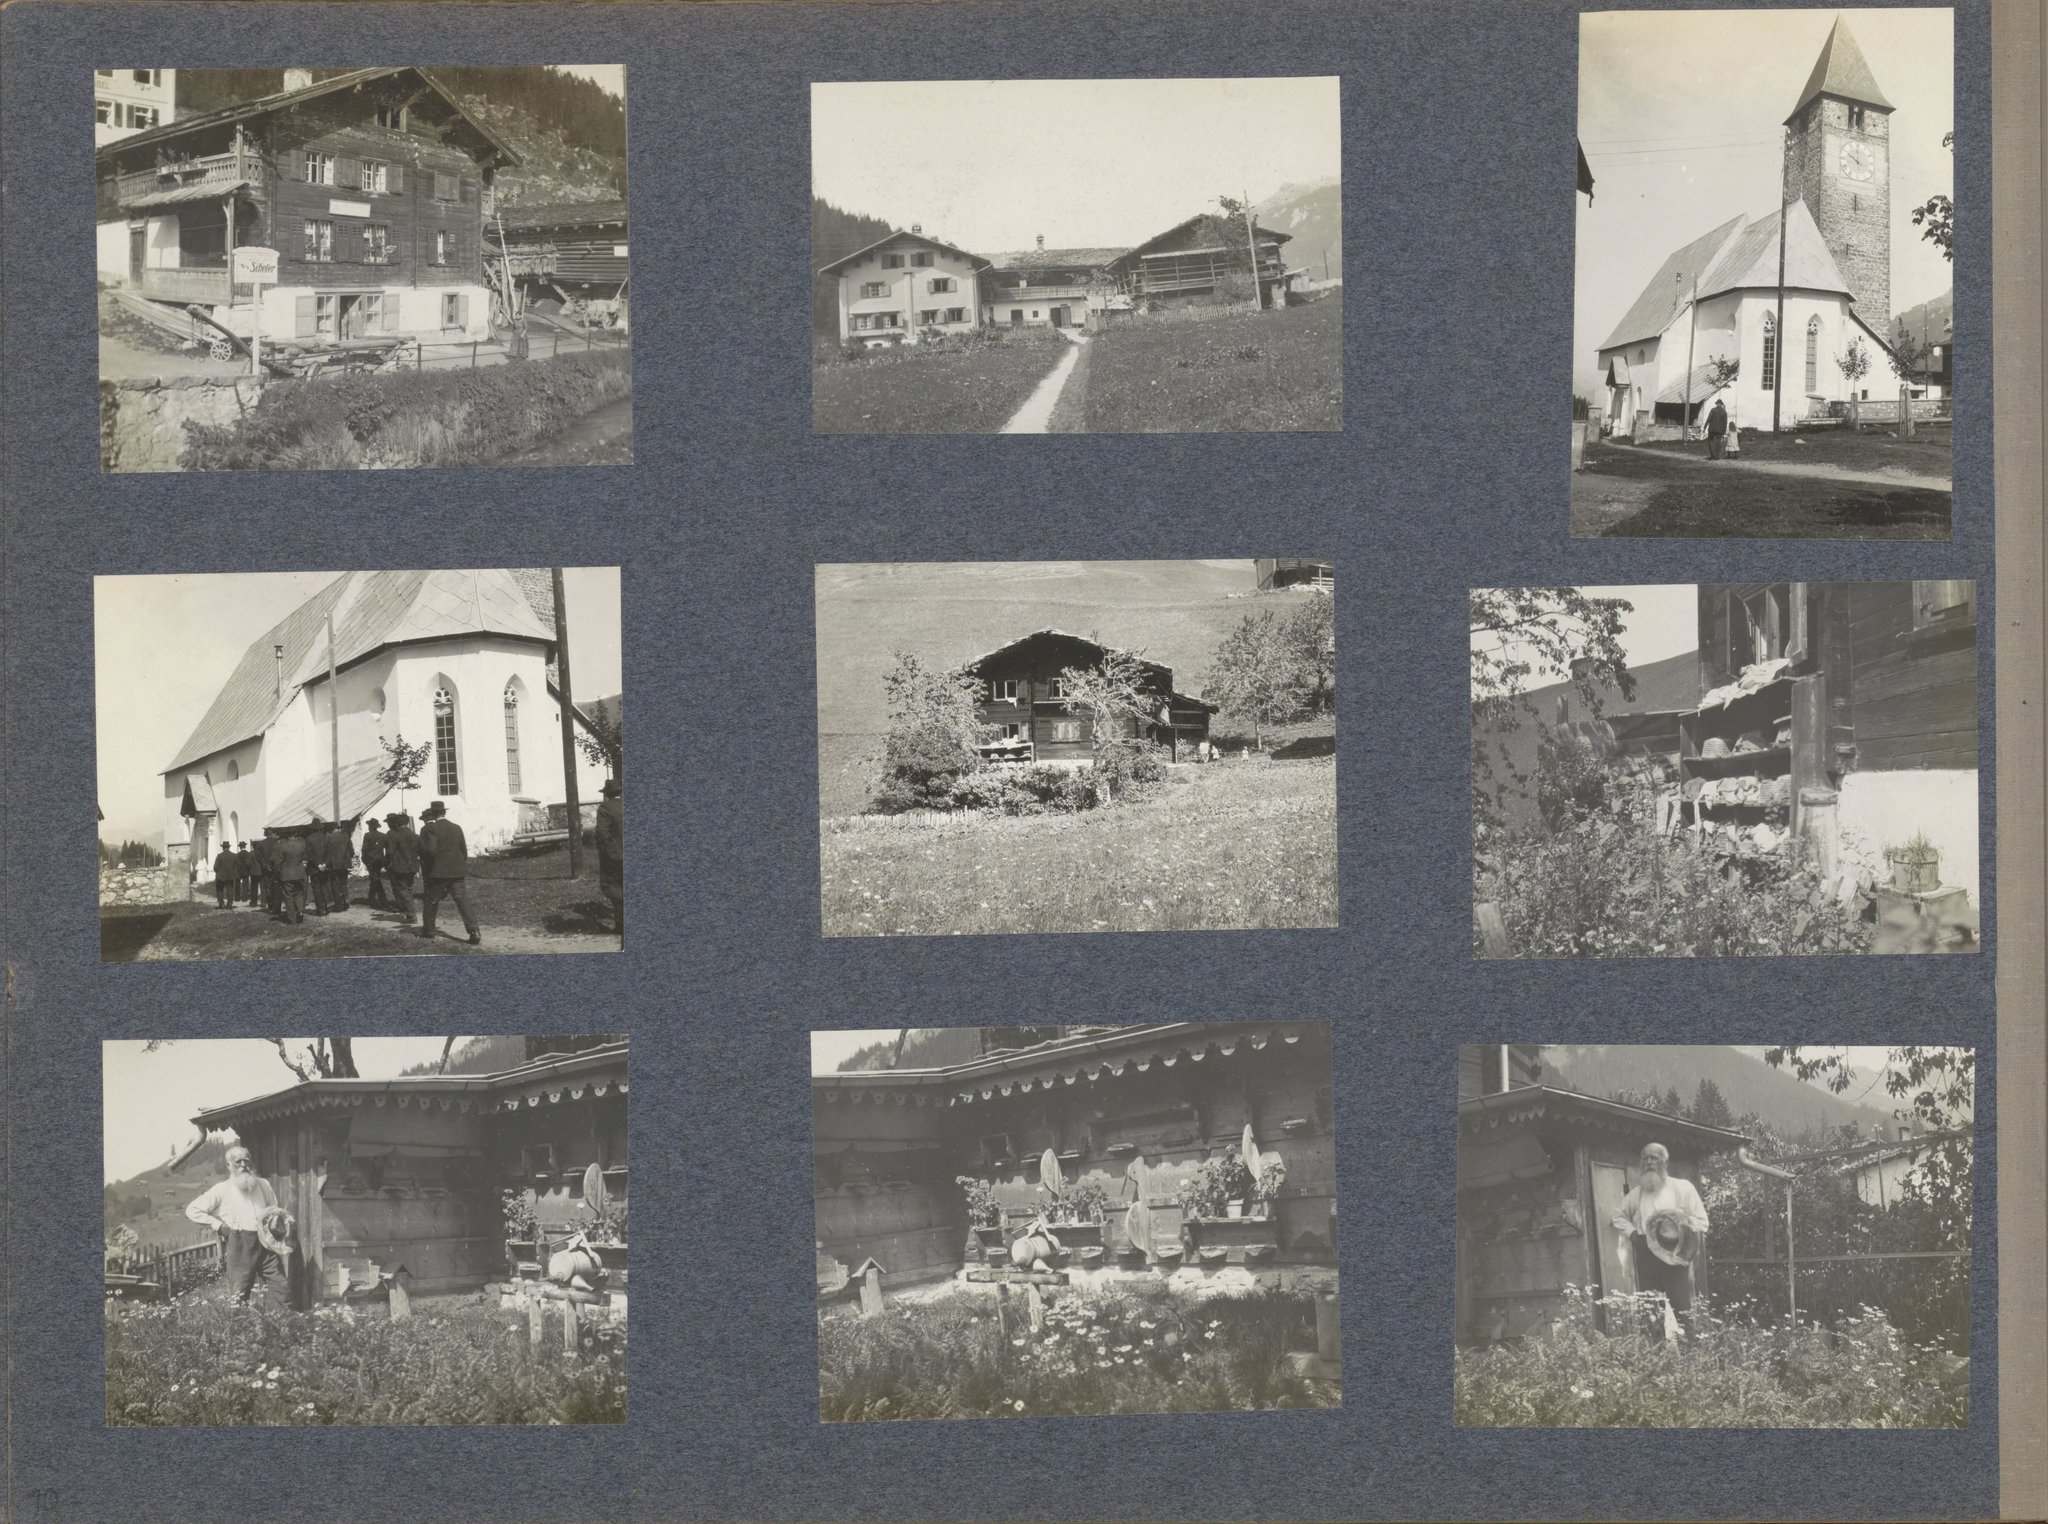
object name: photograph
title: Verblijf in de bergen (1)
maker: Anonymous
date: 1910-1911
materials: cardboard, paper, photographic support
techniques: gelatin silver print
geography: europe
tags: the family travelling, on holiday, recreation, rural housing, e.g. country-house, villa, cottage, church (exterior), mountains, europe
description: Albumblad met negen foto's van dorpsgezichten, mogelijk genomen in de bergen van Zwitserland of Oostenrijk. Afgebeeld zijn chalets, een kerk, kerkgangers, een jong meisje en een man met een grijze baard in een tuin. Onderdeel van Fotoalbum van de familie Palthe uit Almelo.